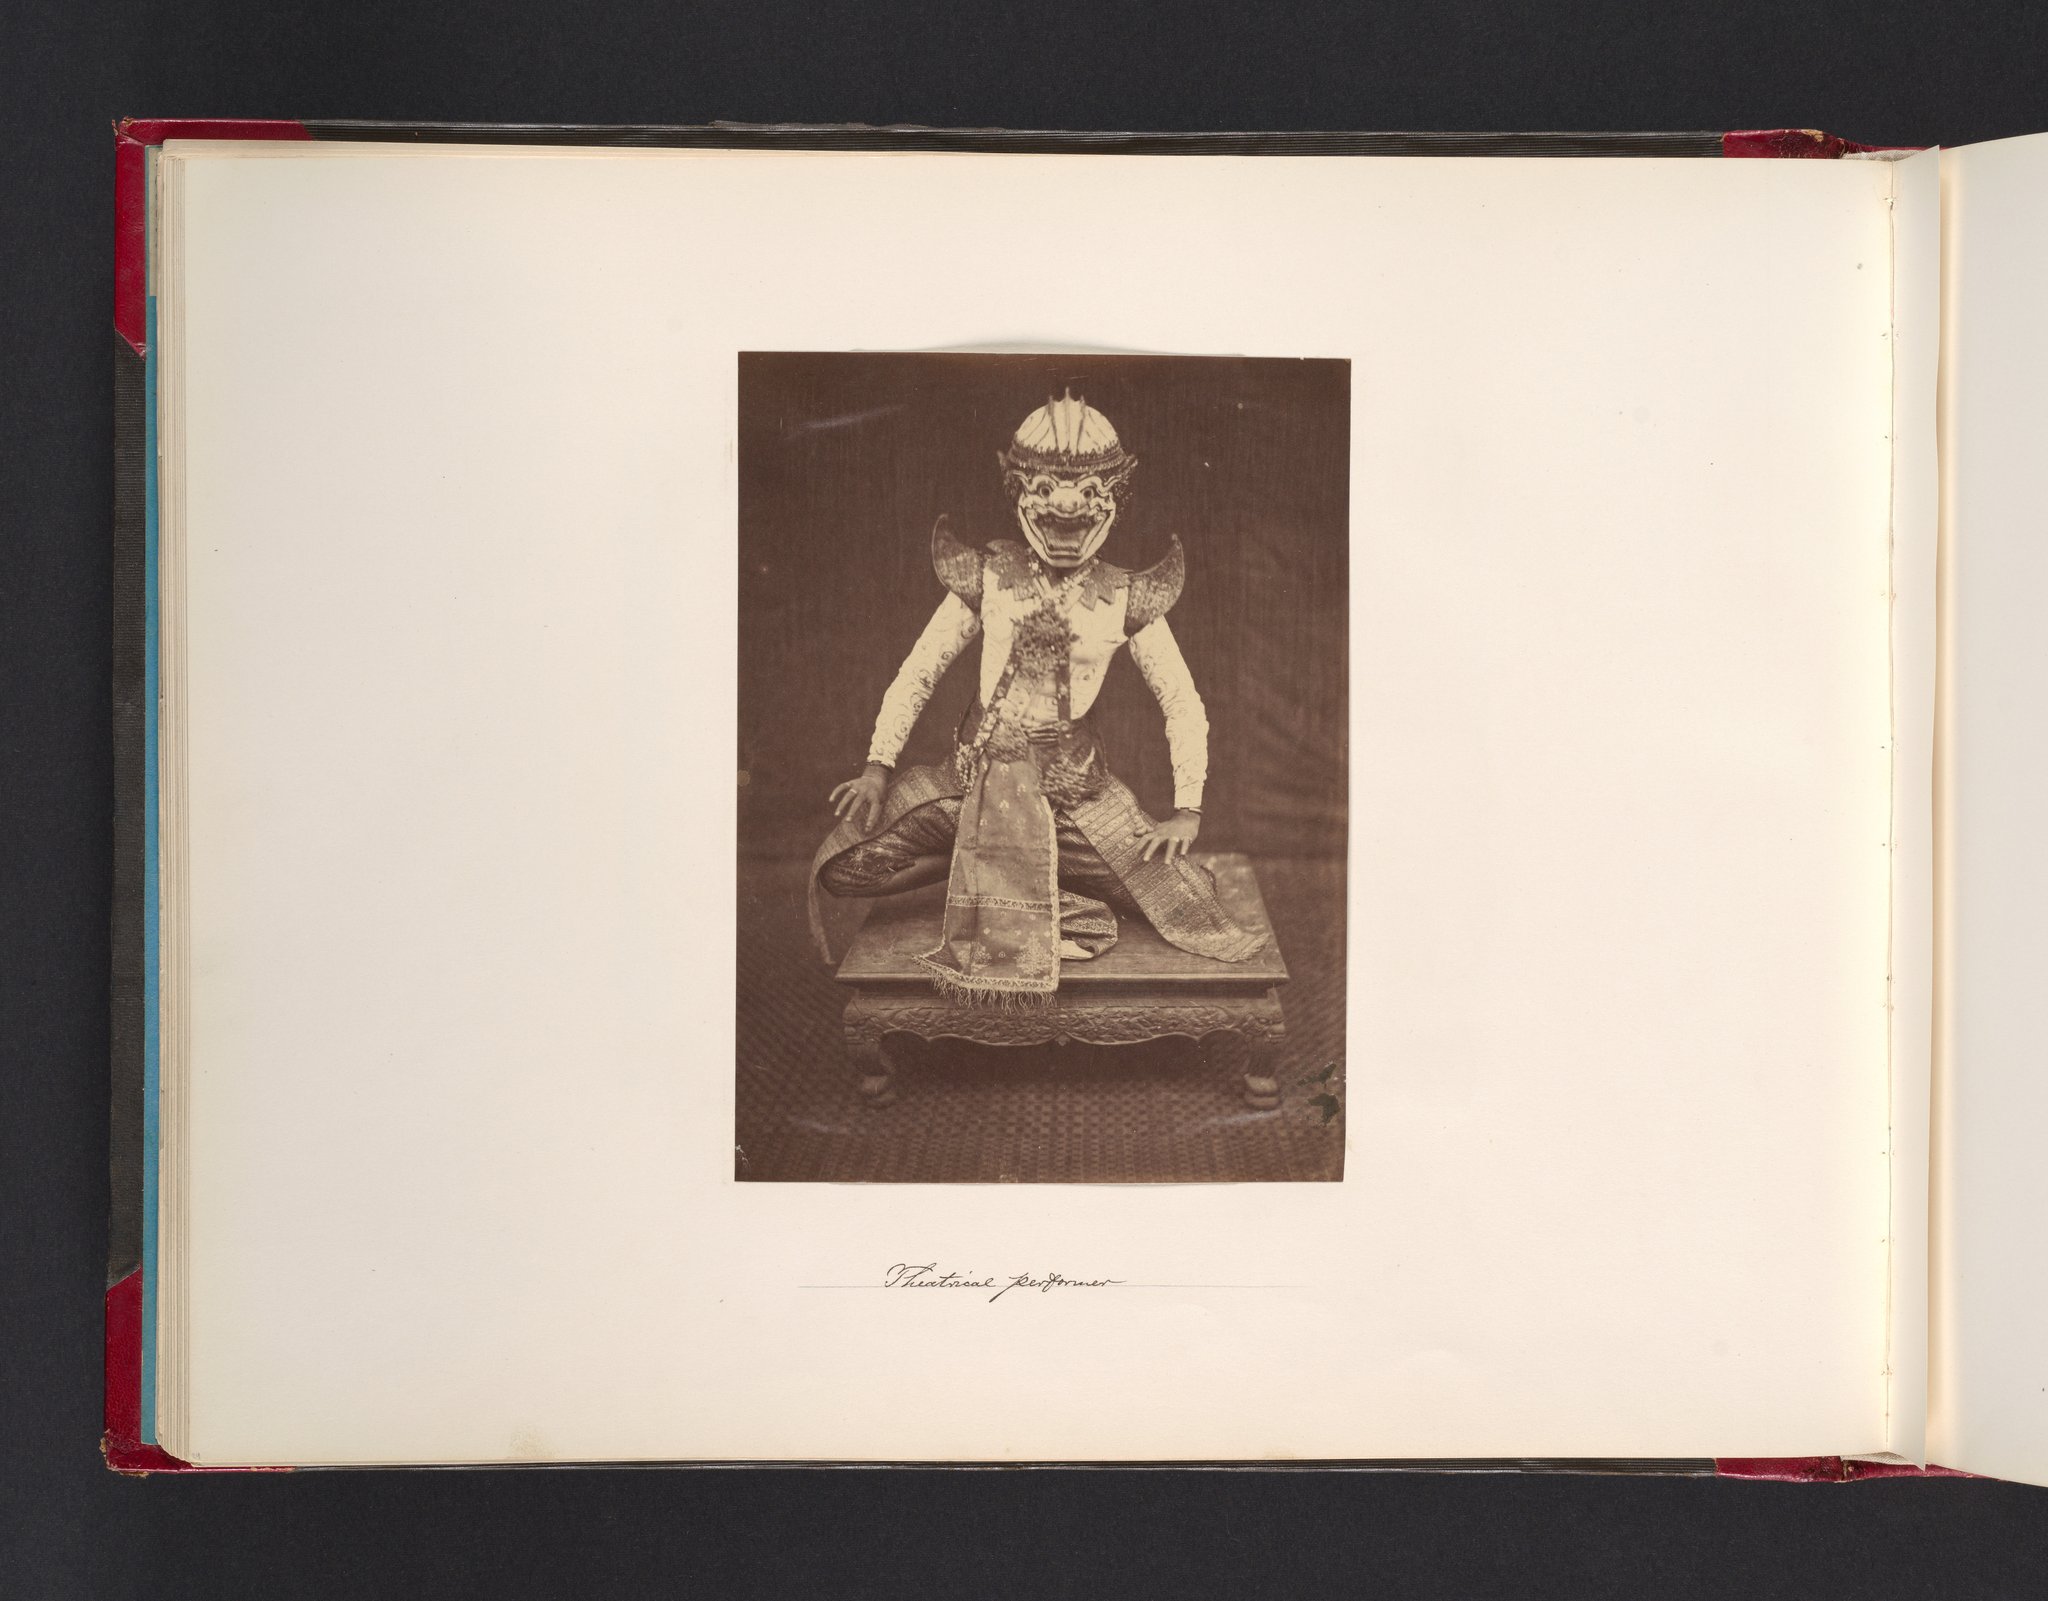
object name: photograph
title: Theatrical Performer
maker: john thomson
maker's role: artist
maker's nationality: british, scottish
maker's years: 1837-1921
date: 1865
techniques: albumen silver print, glass negative